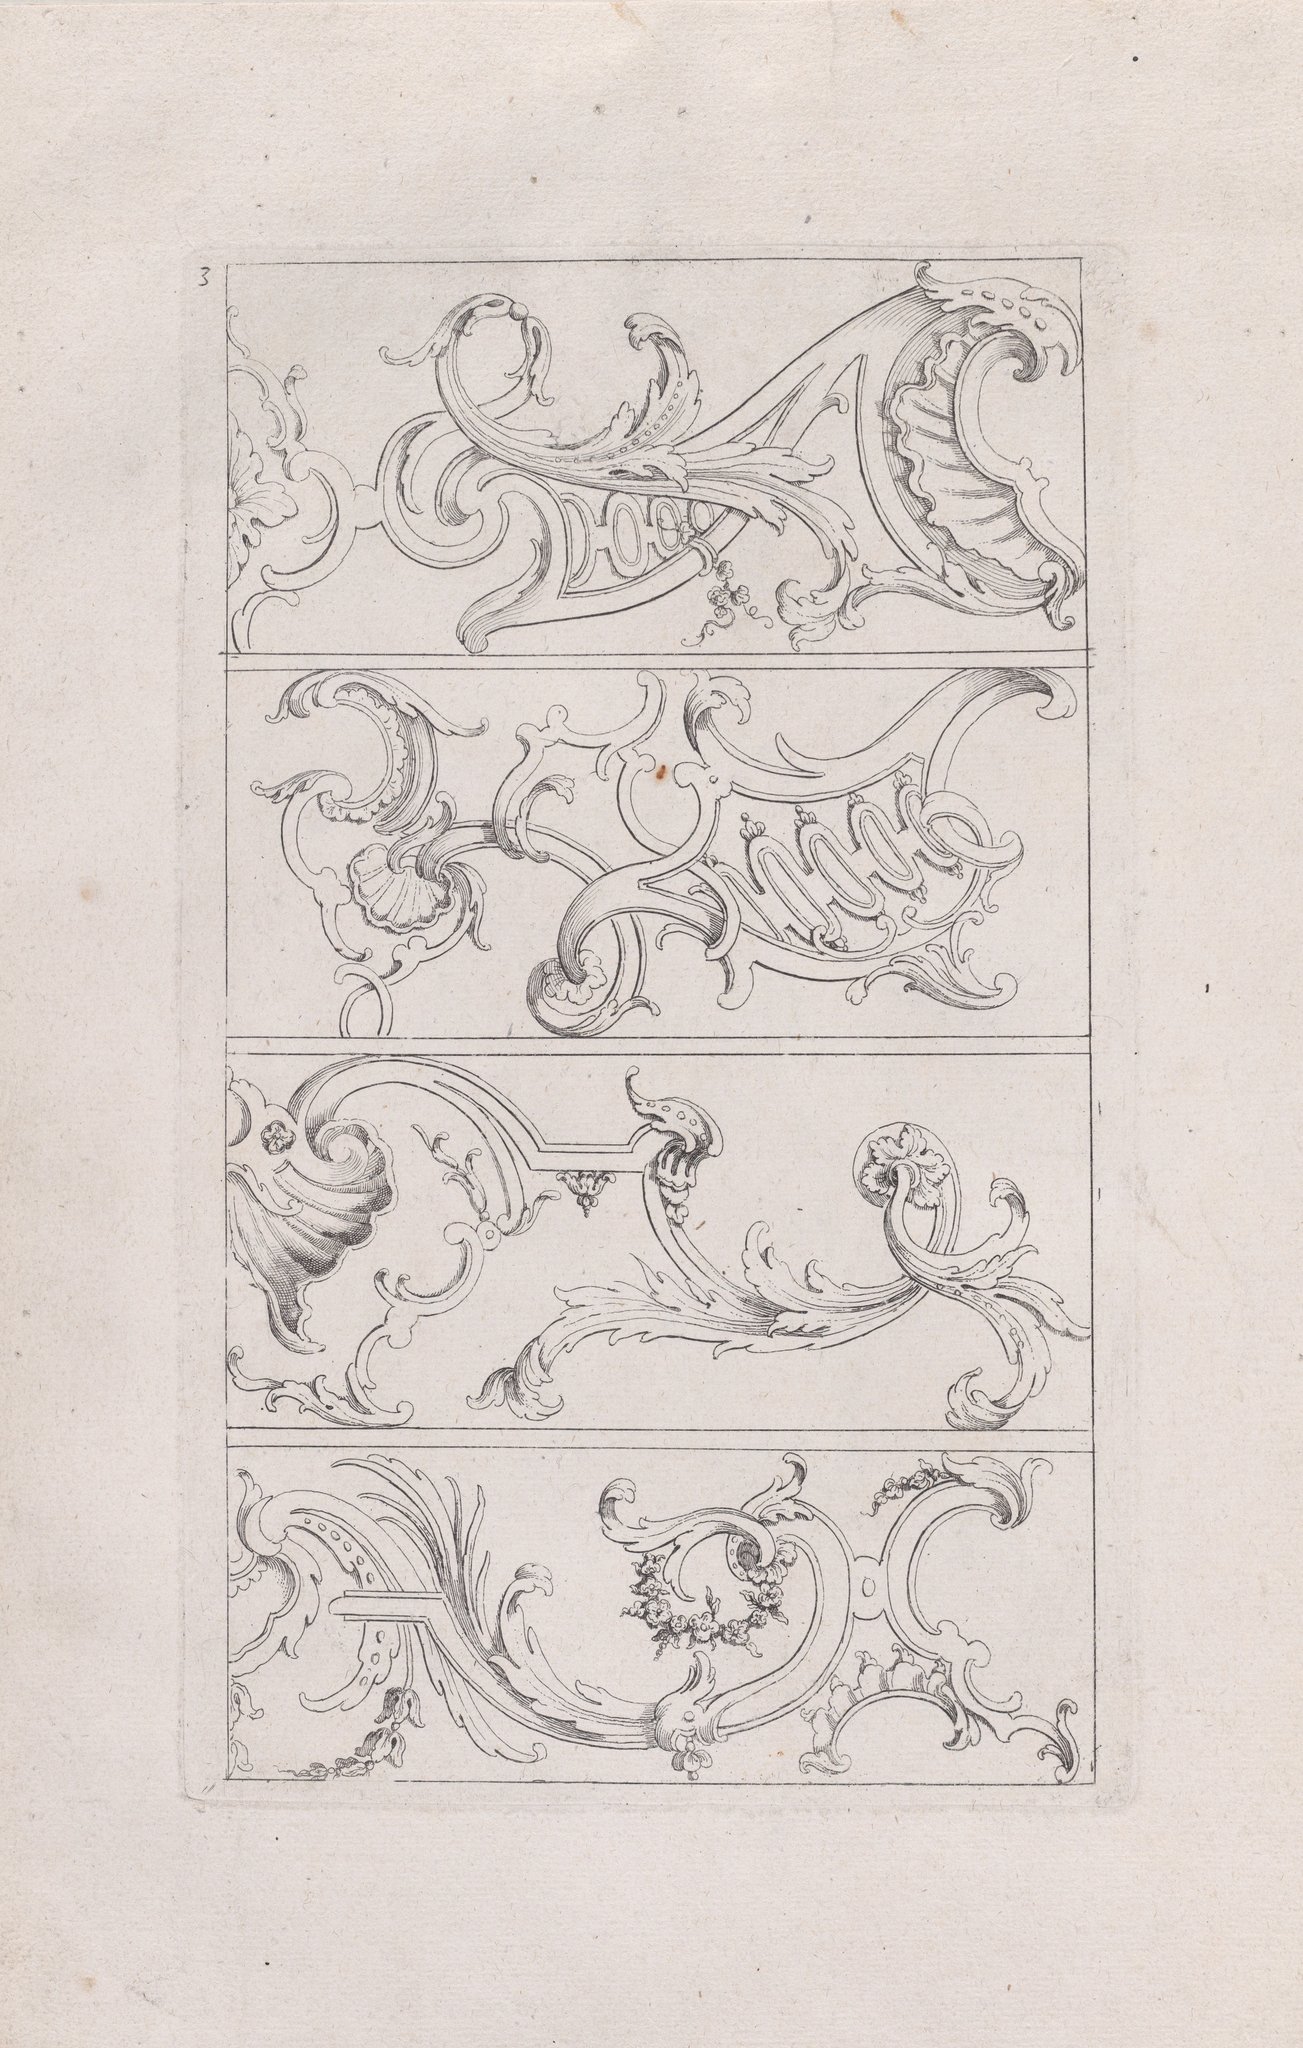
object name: print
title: Plate 3, from "Livre Nouveau de Prinsipes D'Ornemens, tres facil. Pour apprendre a Dessigner"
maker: nicolas guérard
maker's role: artist and publisher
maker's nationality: french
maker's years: 1648-1719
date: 1715-1725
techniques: engraving